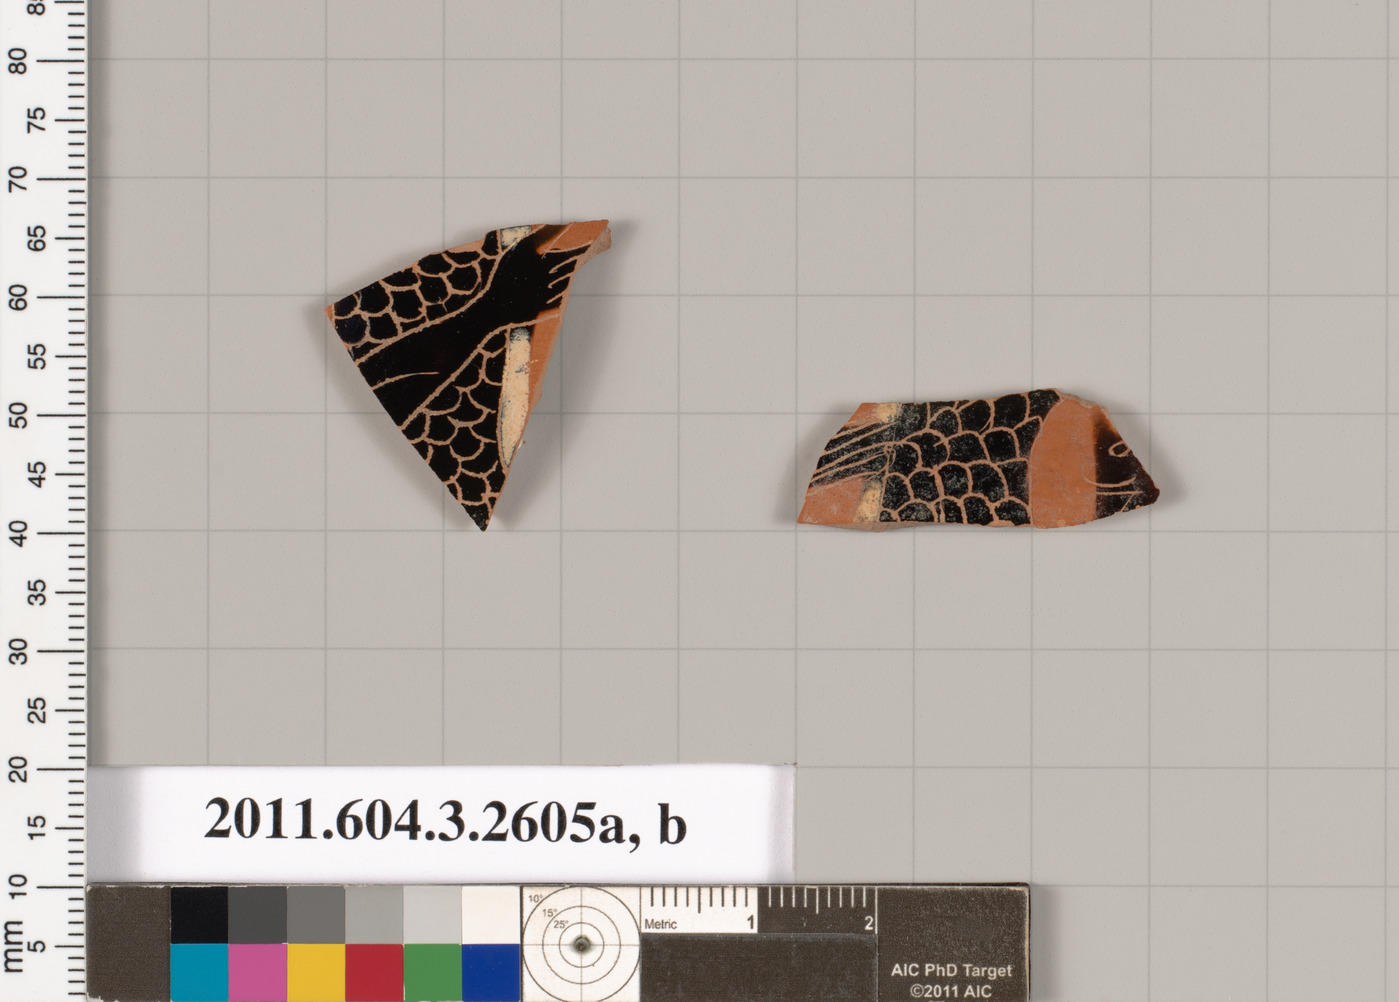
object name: kylix fragment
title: Terracotta fragments of a kylix (drinking cup)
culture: greek, attic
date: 550-526 BCE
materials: terracotta